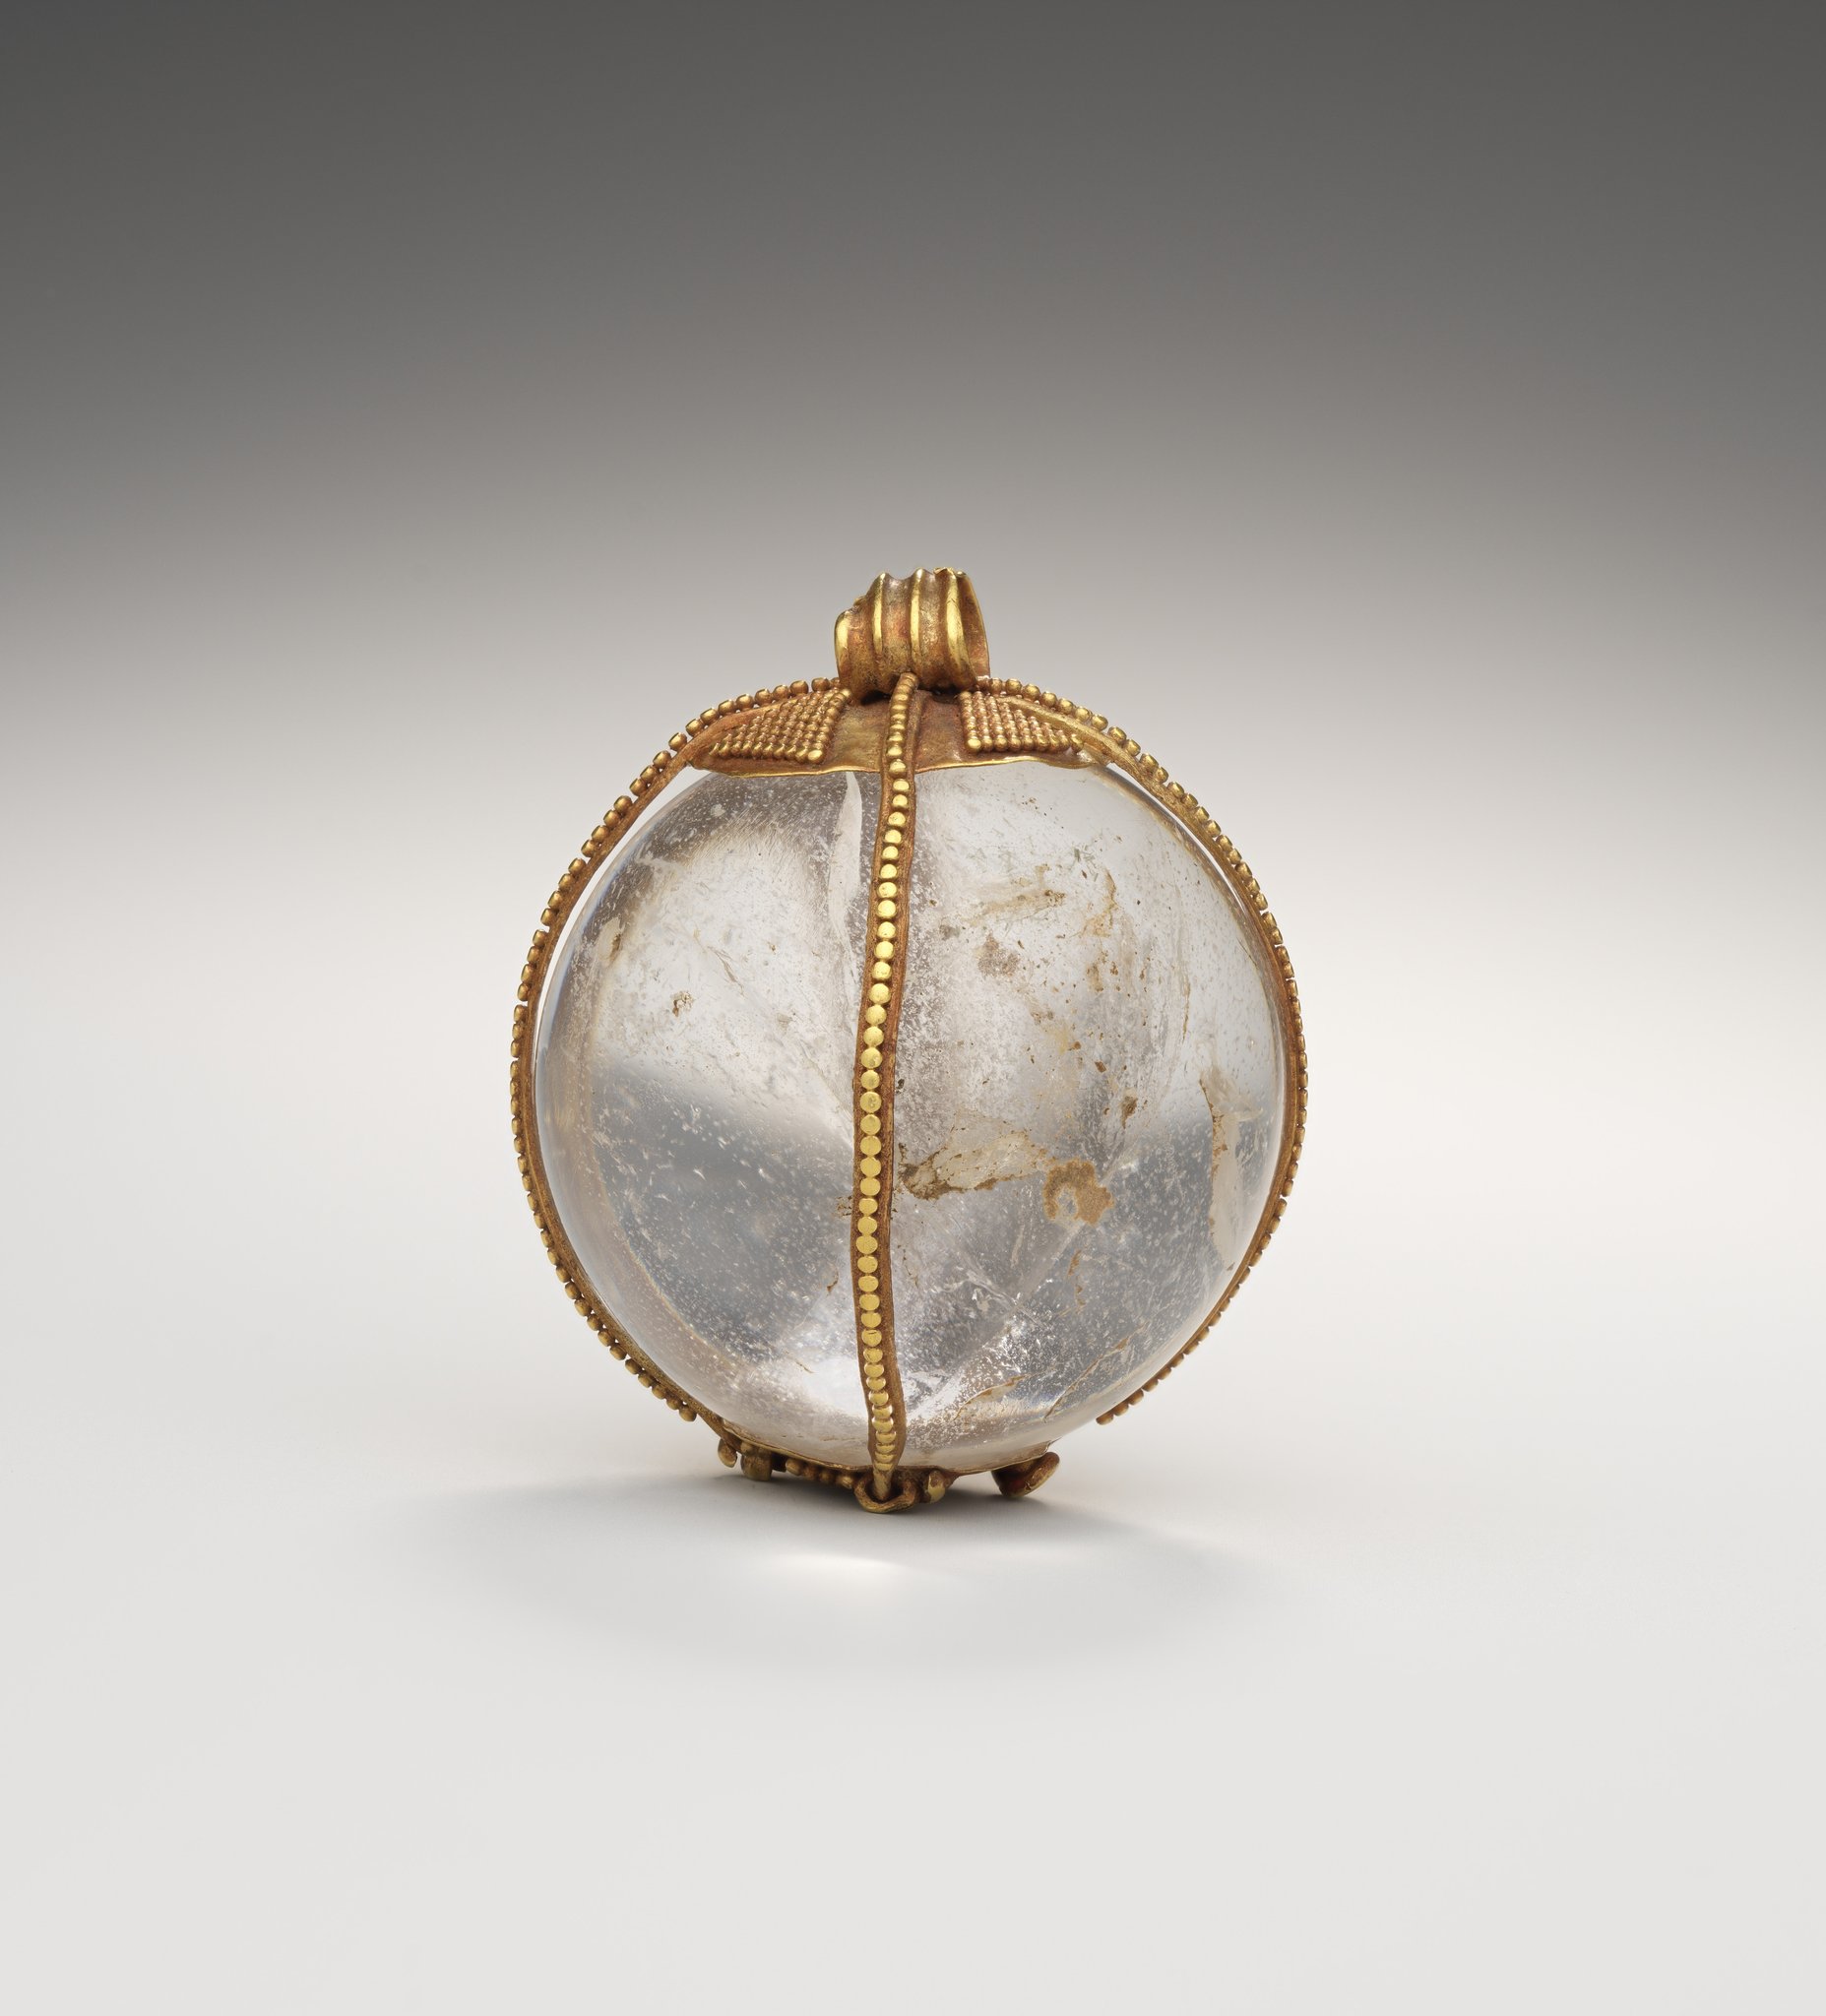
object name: pendant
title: Rock Crystal Amuletic Sphere Pendant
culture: frankish or hunnic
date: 301-500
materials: gold, quartz